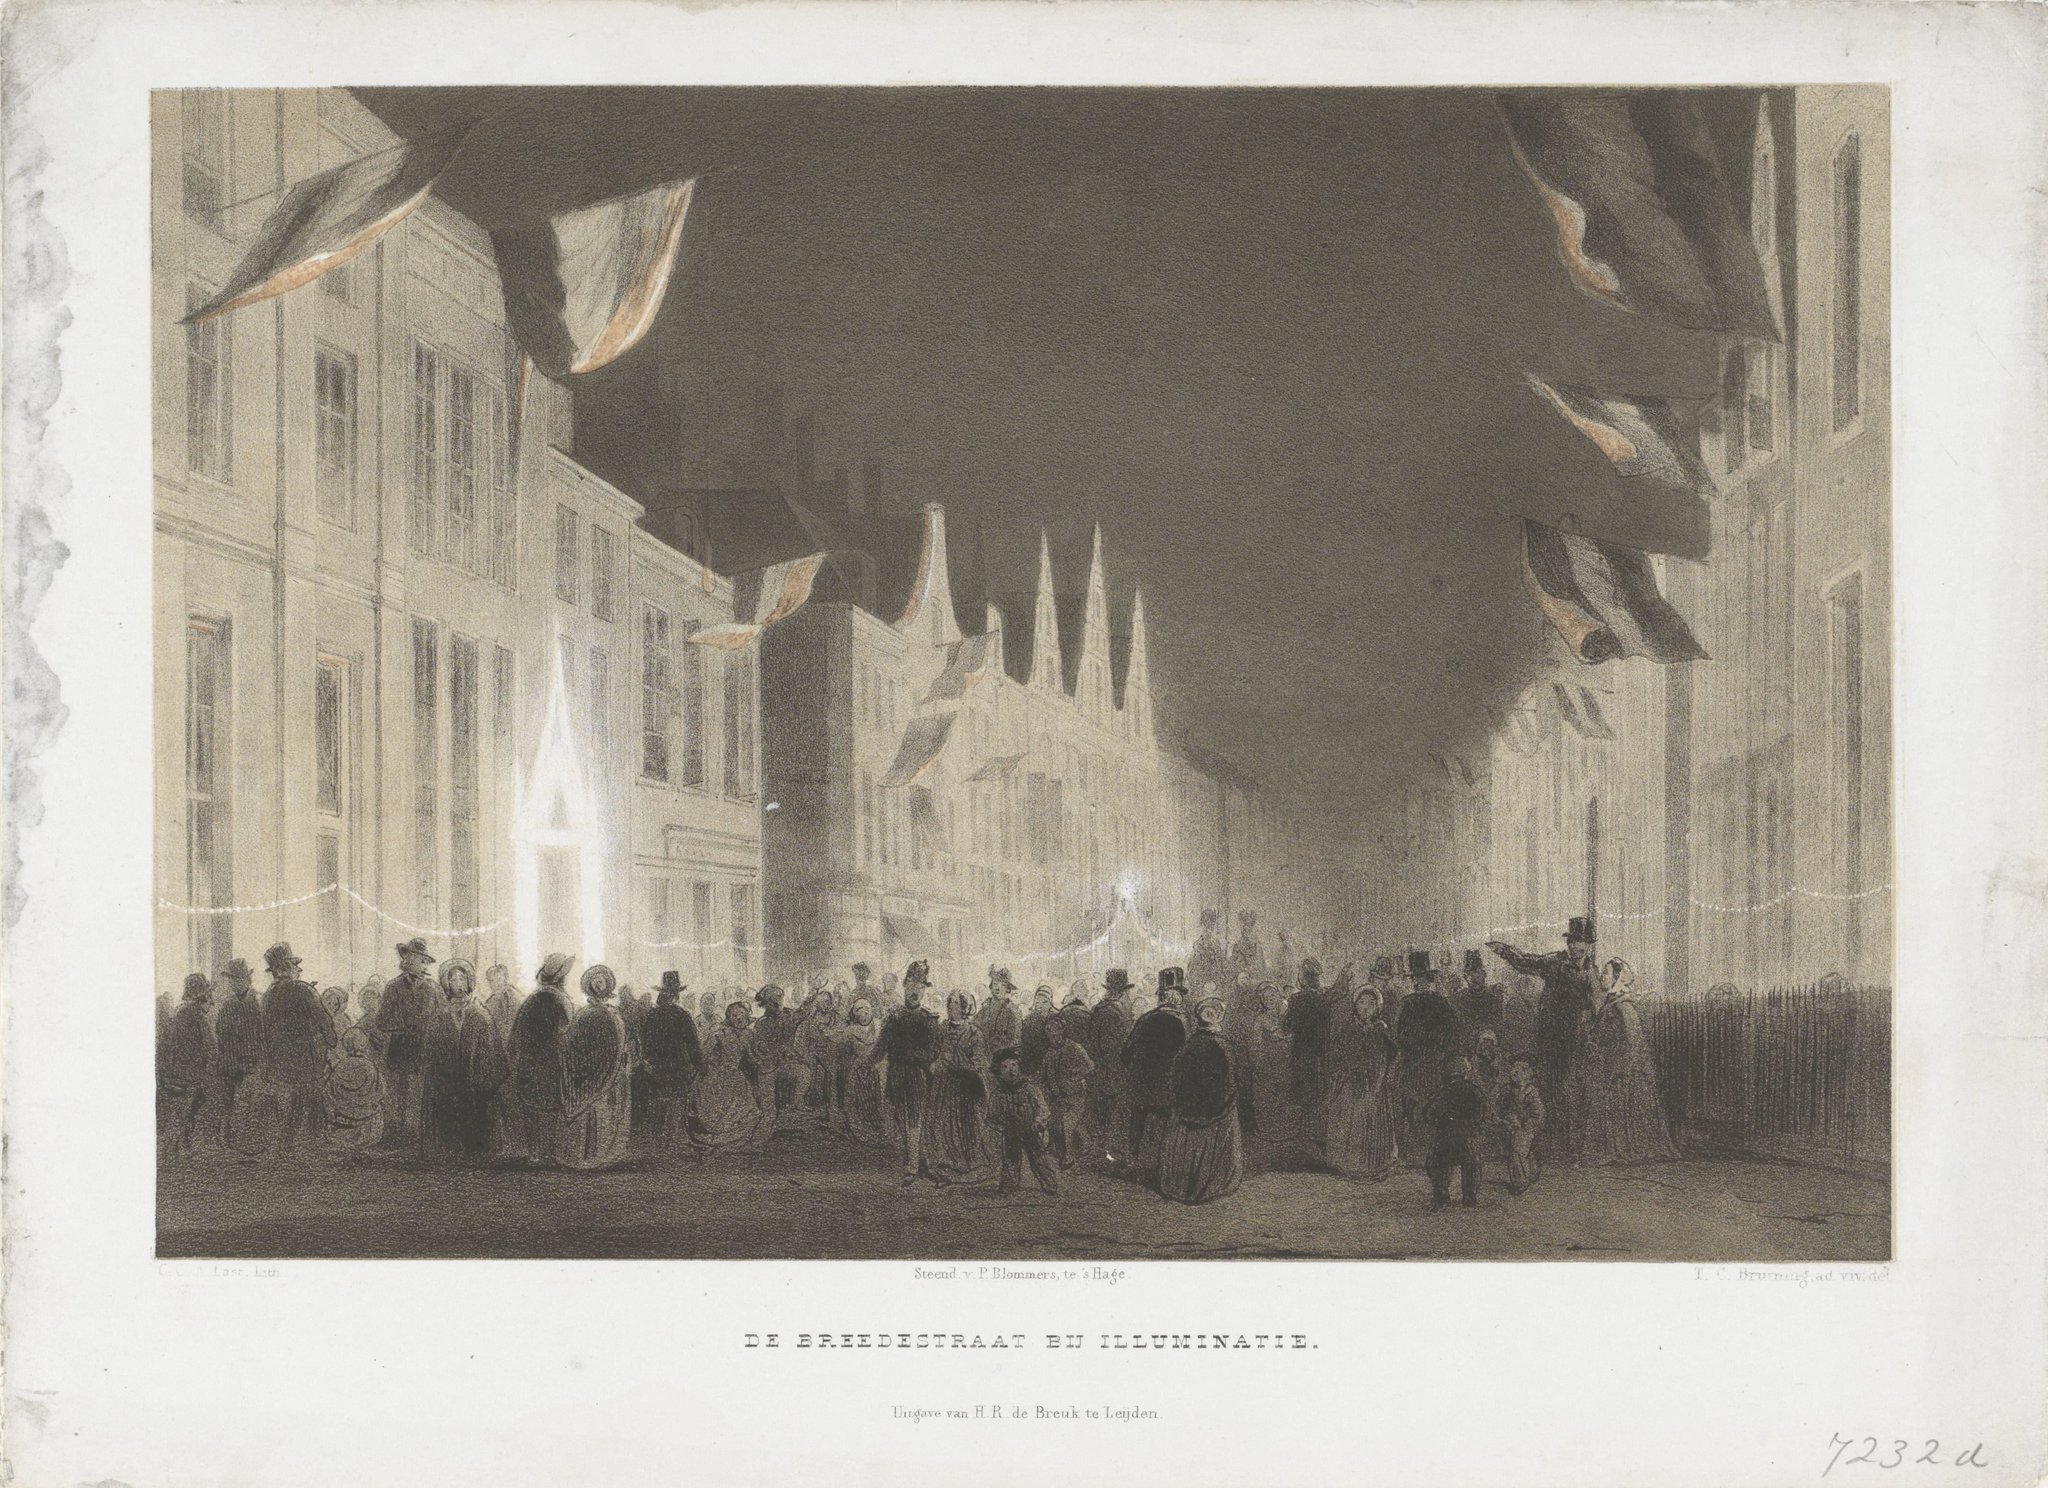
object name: print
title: De Breedestraat bij illuminiatie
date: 1855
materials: paper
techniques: hand coloring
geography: leiden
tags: festivities (+ illumination, fire-works ~ festive activities), commemoration of the founding of a university, leiden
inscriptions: collector's mark: Lugt 2228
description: Illuminatie in de Breestraat. Onderdeel van een serie van zes platen van de feestelijkheden georganiseeerd door de Leidse studenten bij de viering van de 280ste dies natalis van de Leidse Hogeschool, 11-13 juni 1855.